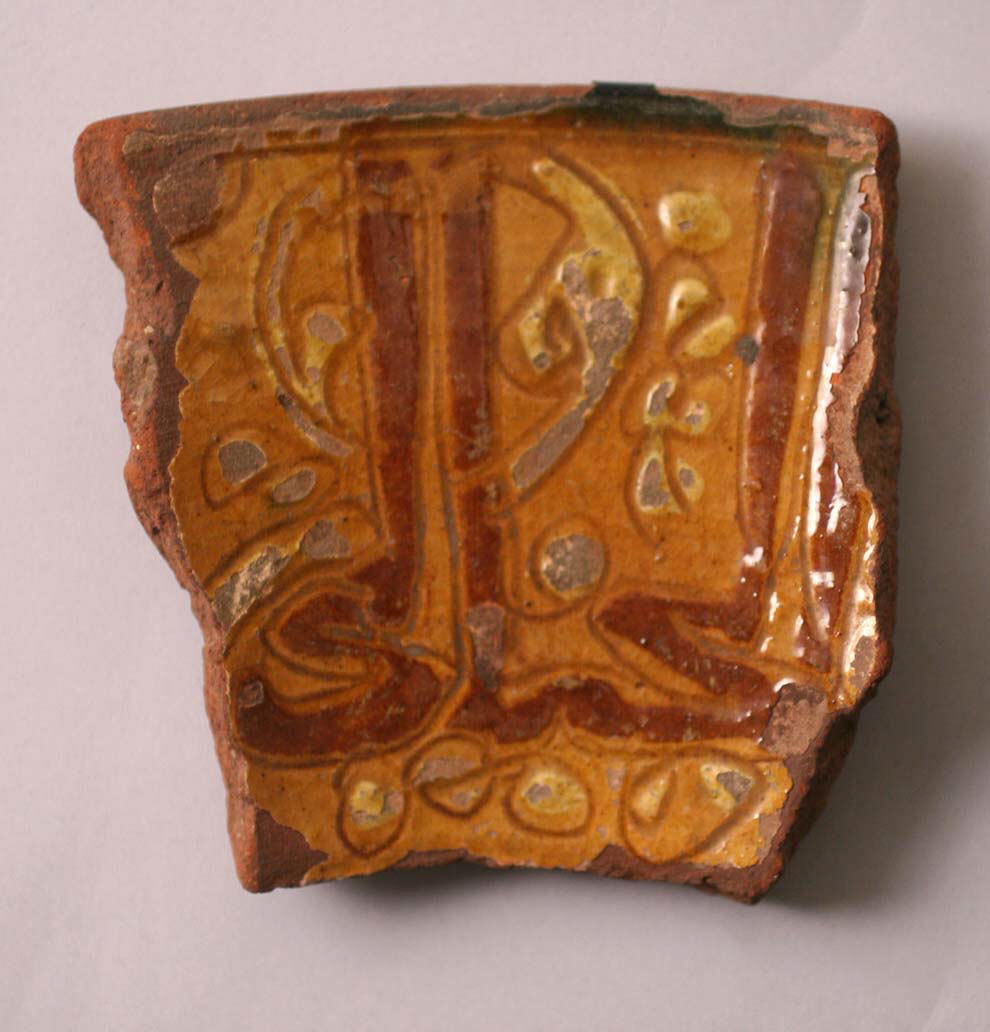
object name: ceramic fragment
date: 1301-1500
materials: earthenware, glaze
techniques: coloring, incising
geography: egypt